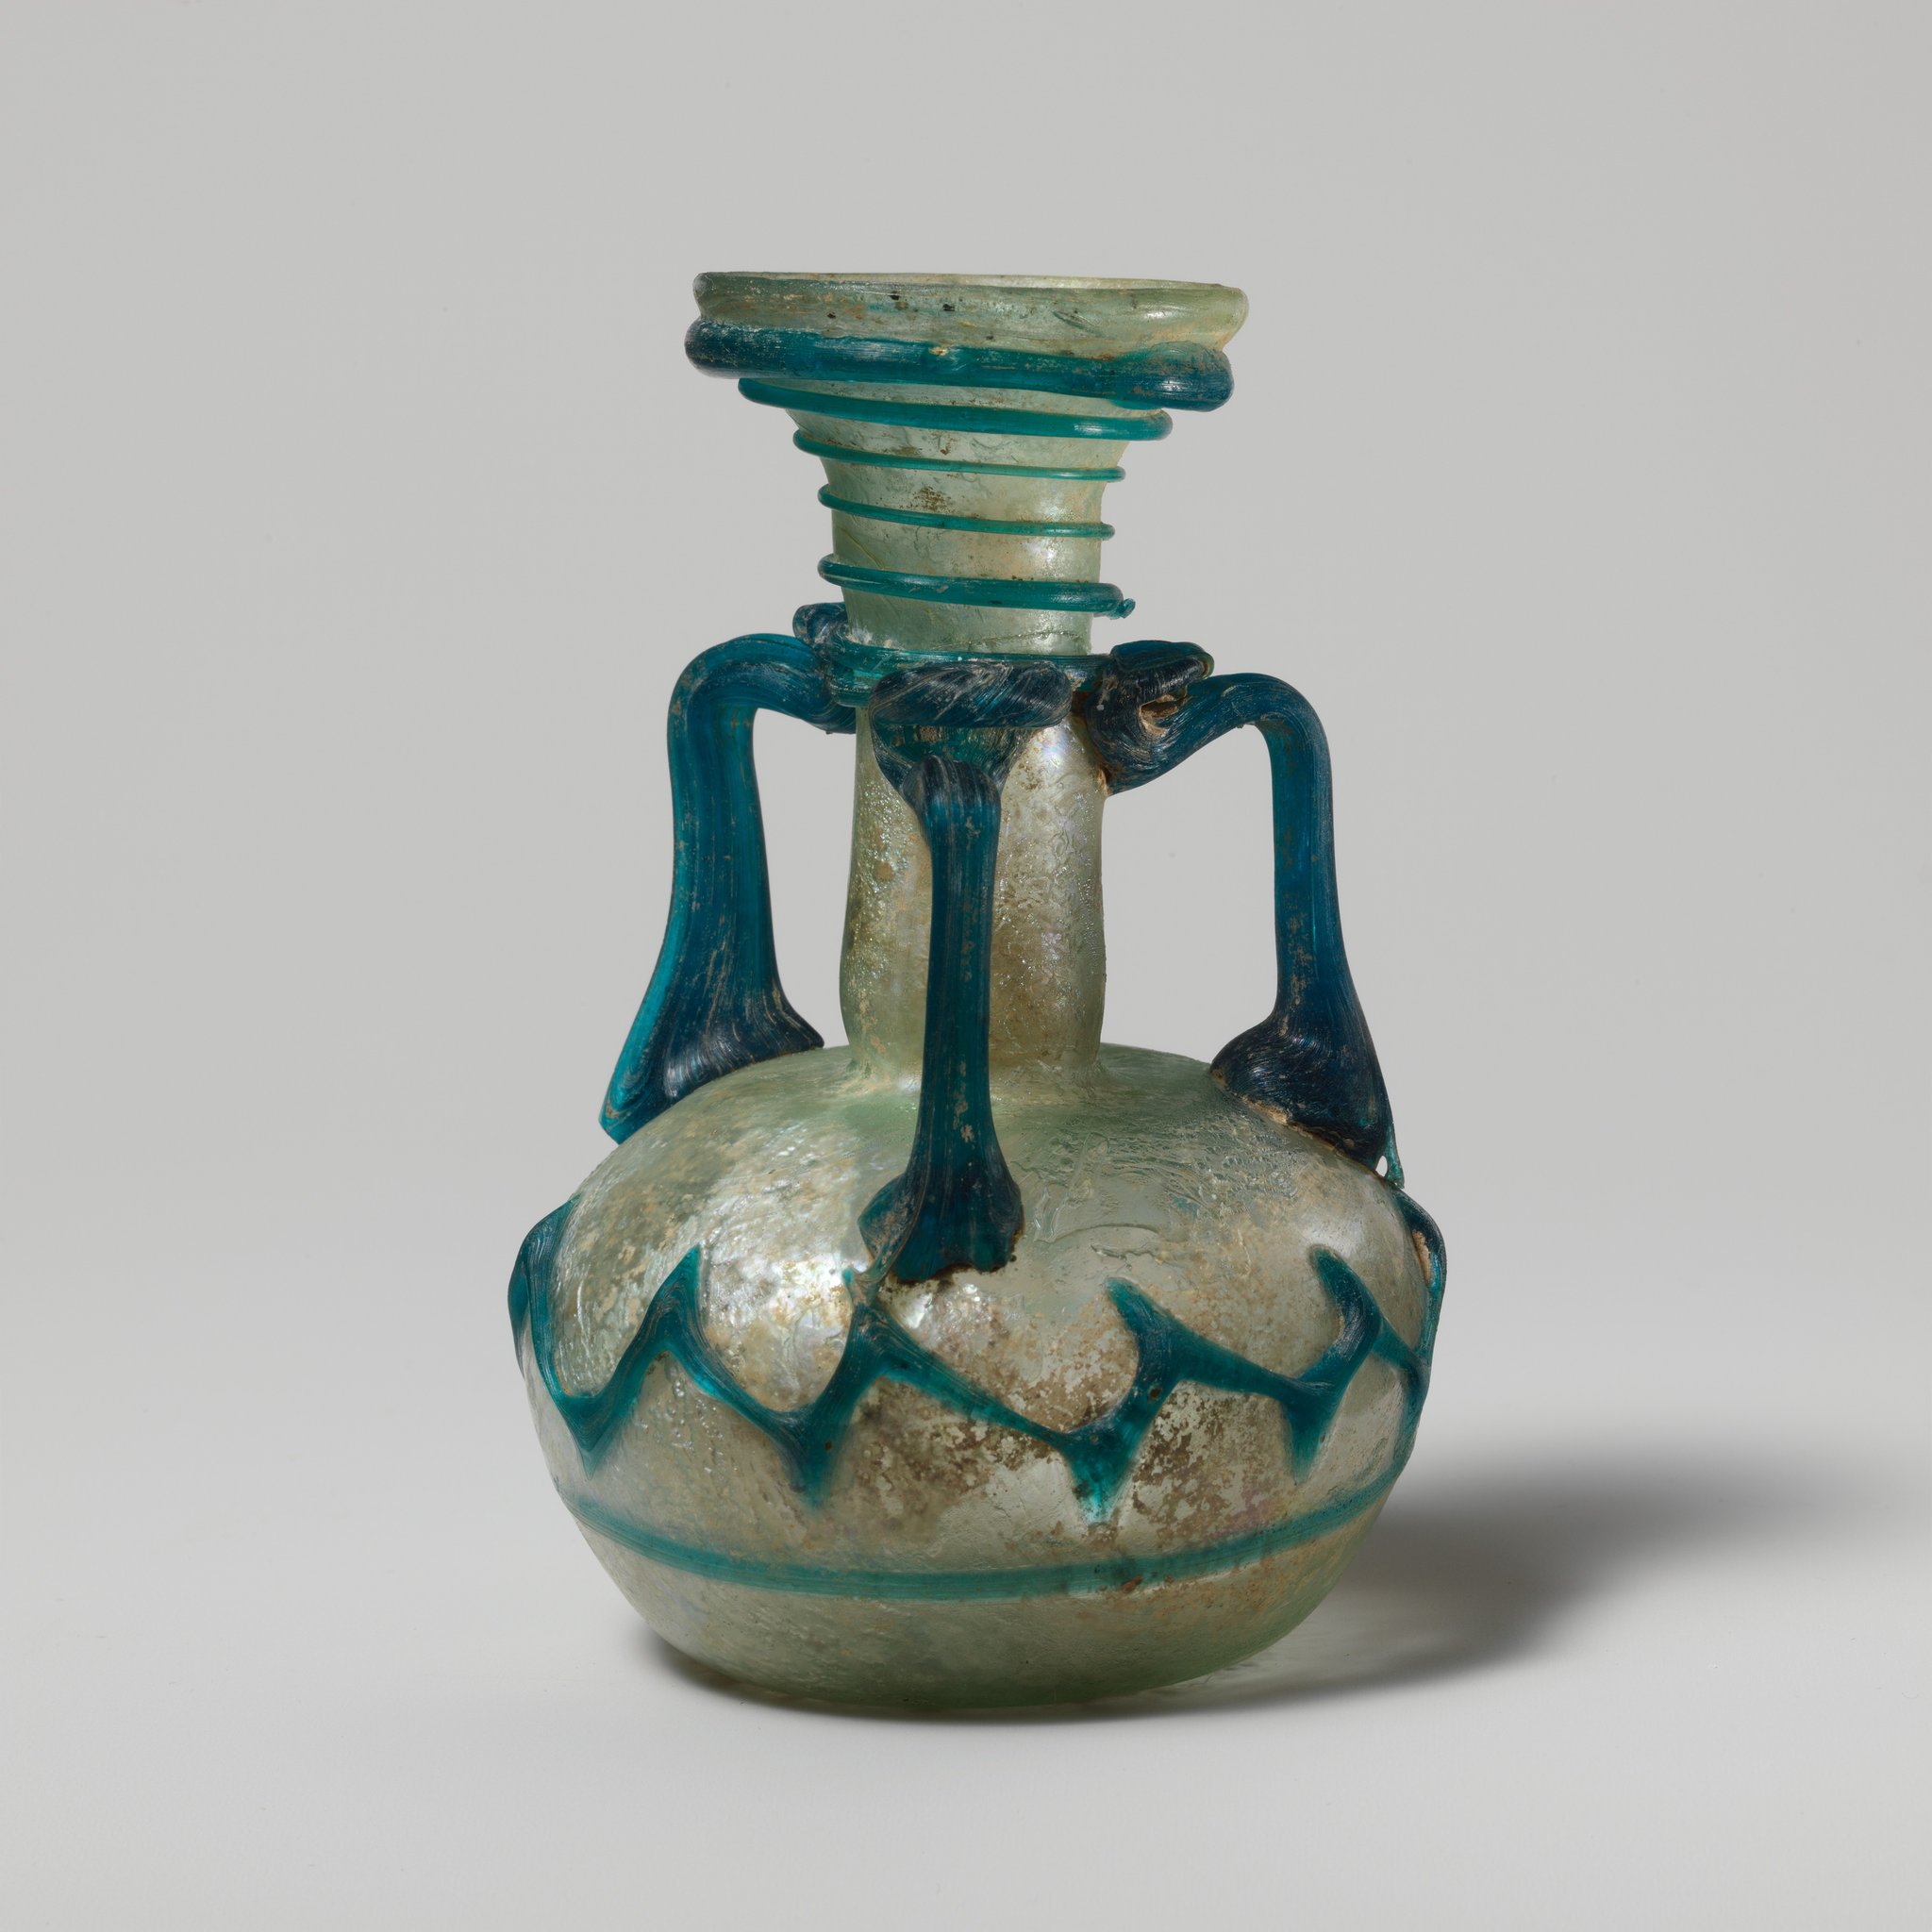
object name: bottle, two handled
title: Glass bottle with handles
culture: roman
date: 301-500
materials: glass